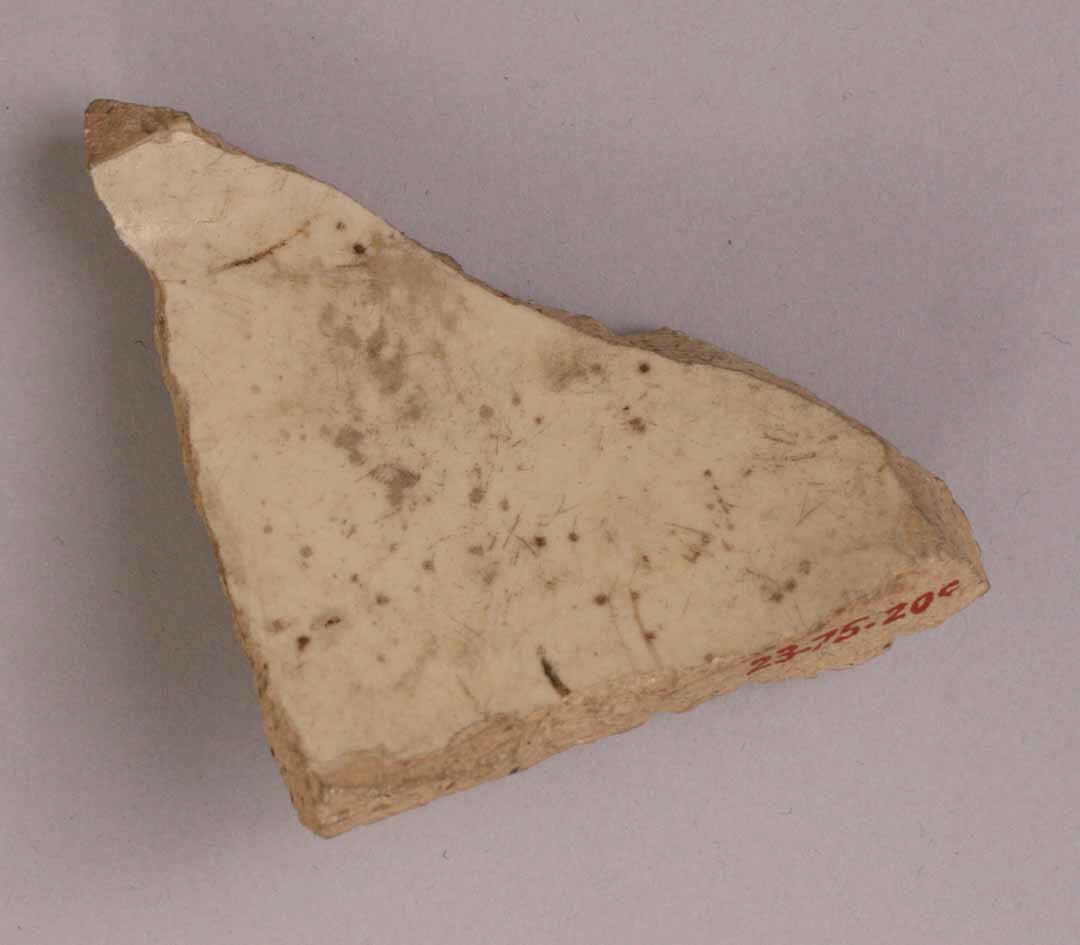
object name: ceramic fragment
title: Fragment of Porcelaneous Ware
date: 801-900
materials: glaze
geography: iraq